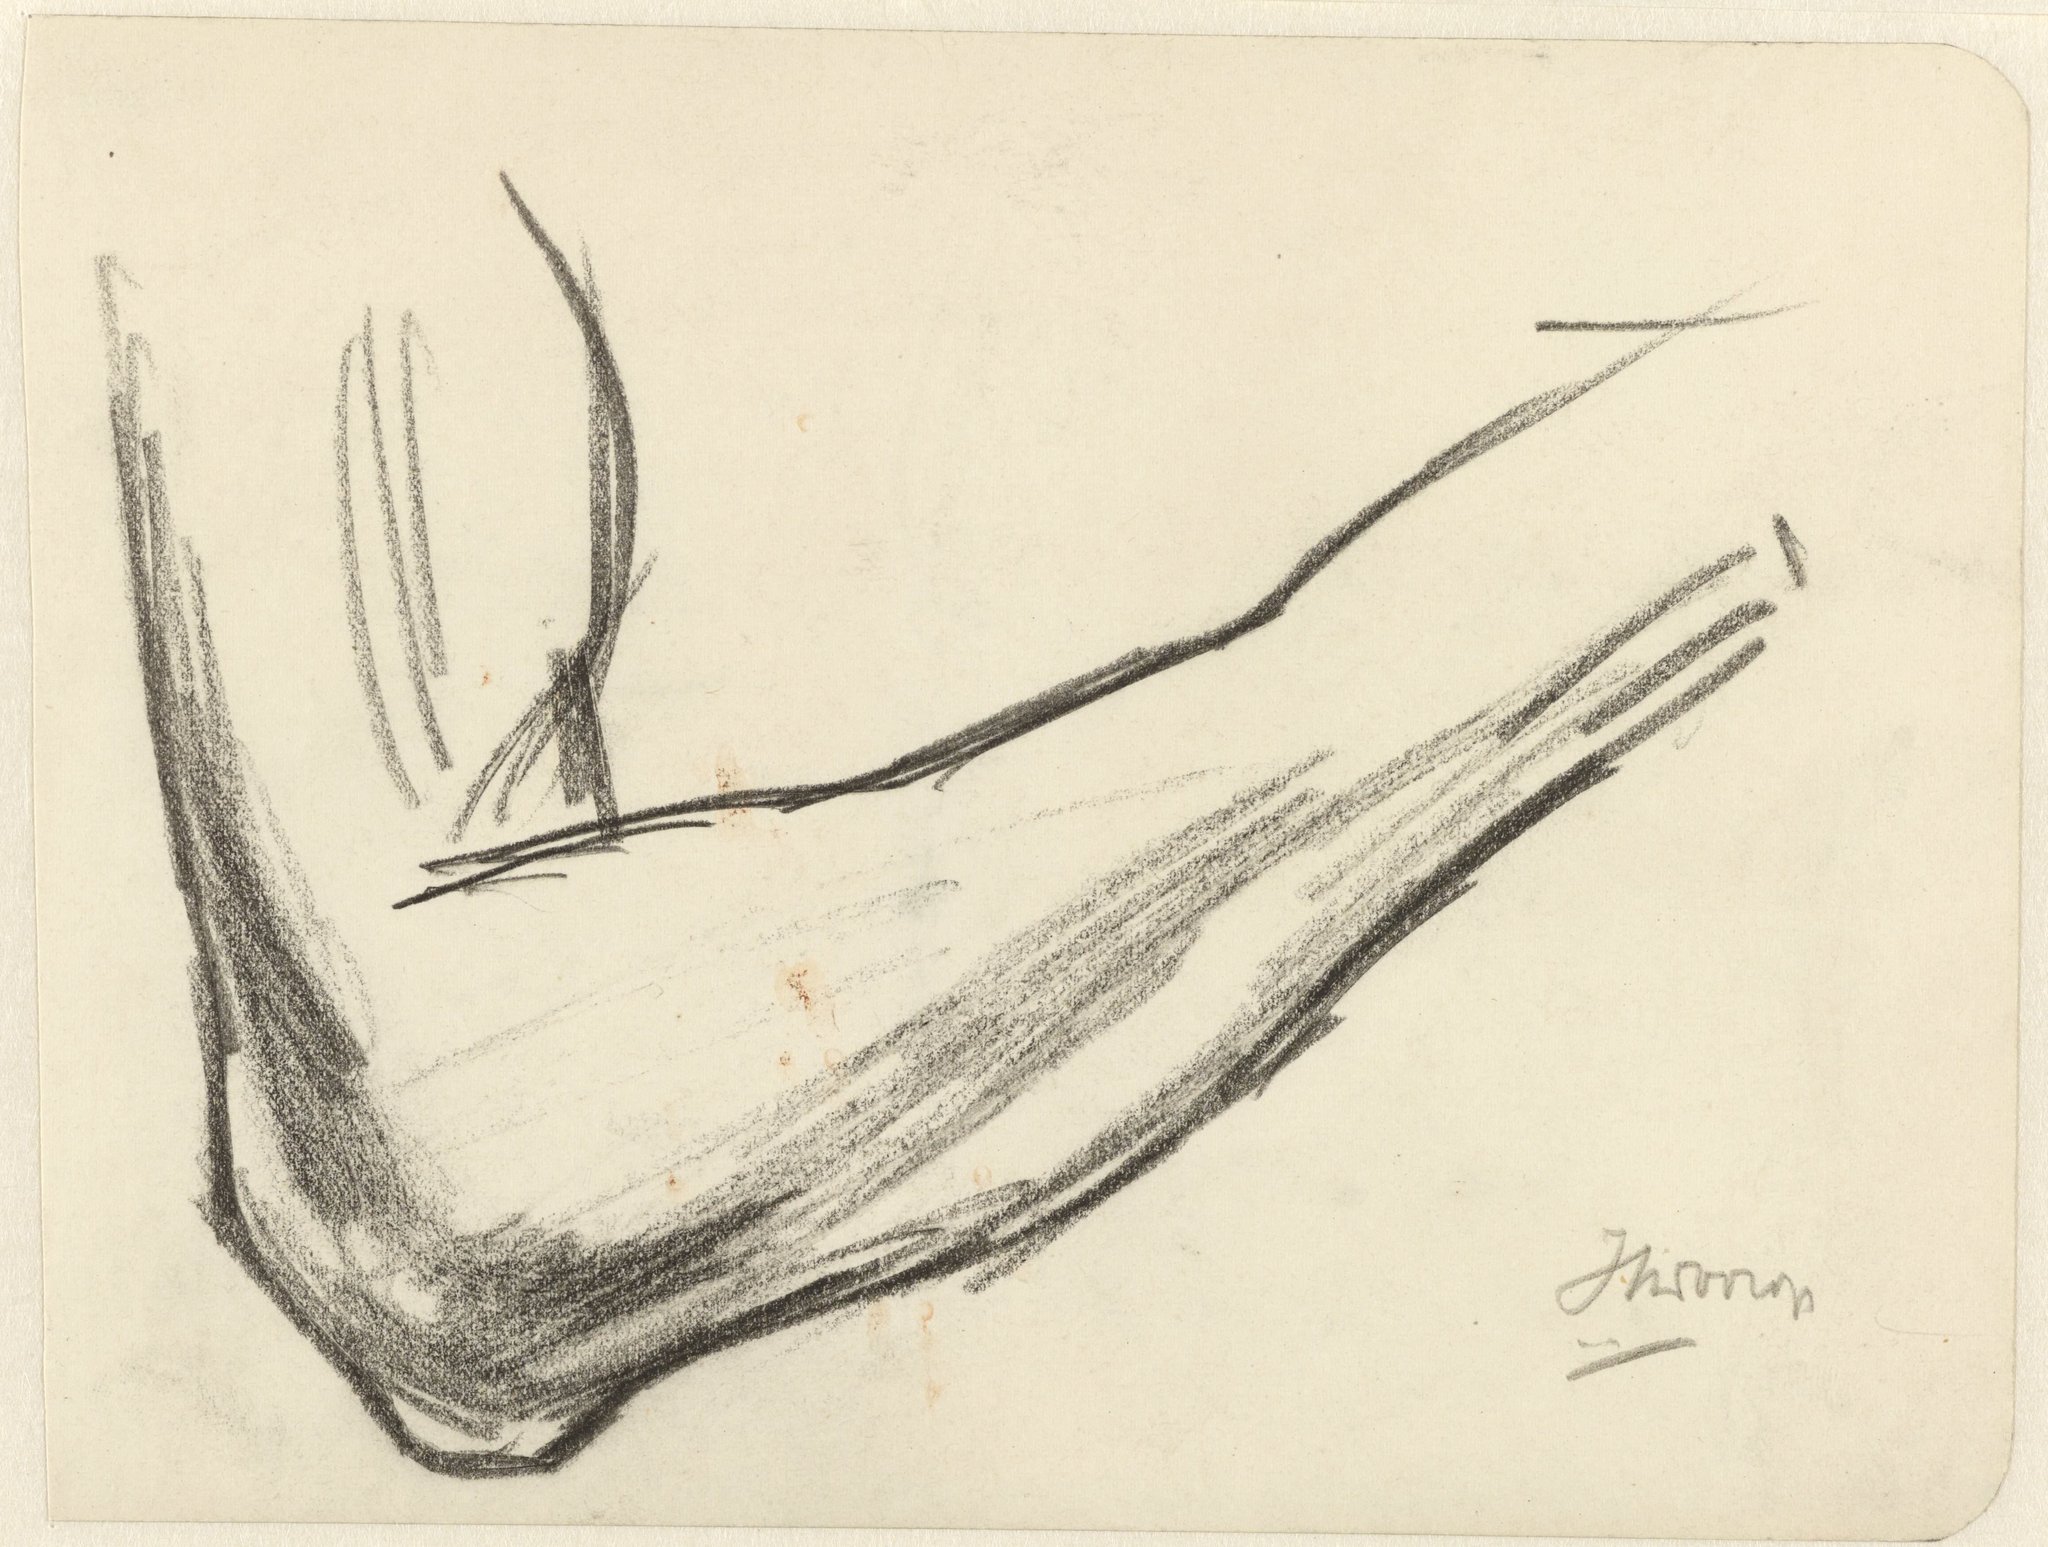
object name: drawing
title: Studie van een arm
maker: jan toorop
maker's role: draughtsman, painter, print maker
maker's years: 1858-1928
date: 1868-1928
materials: chalk, paper